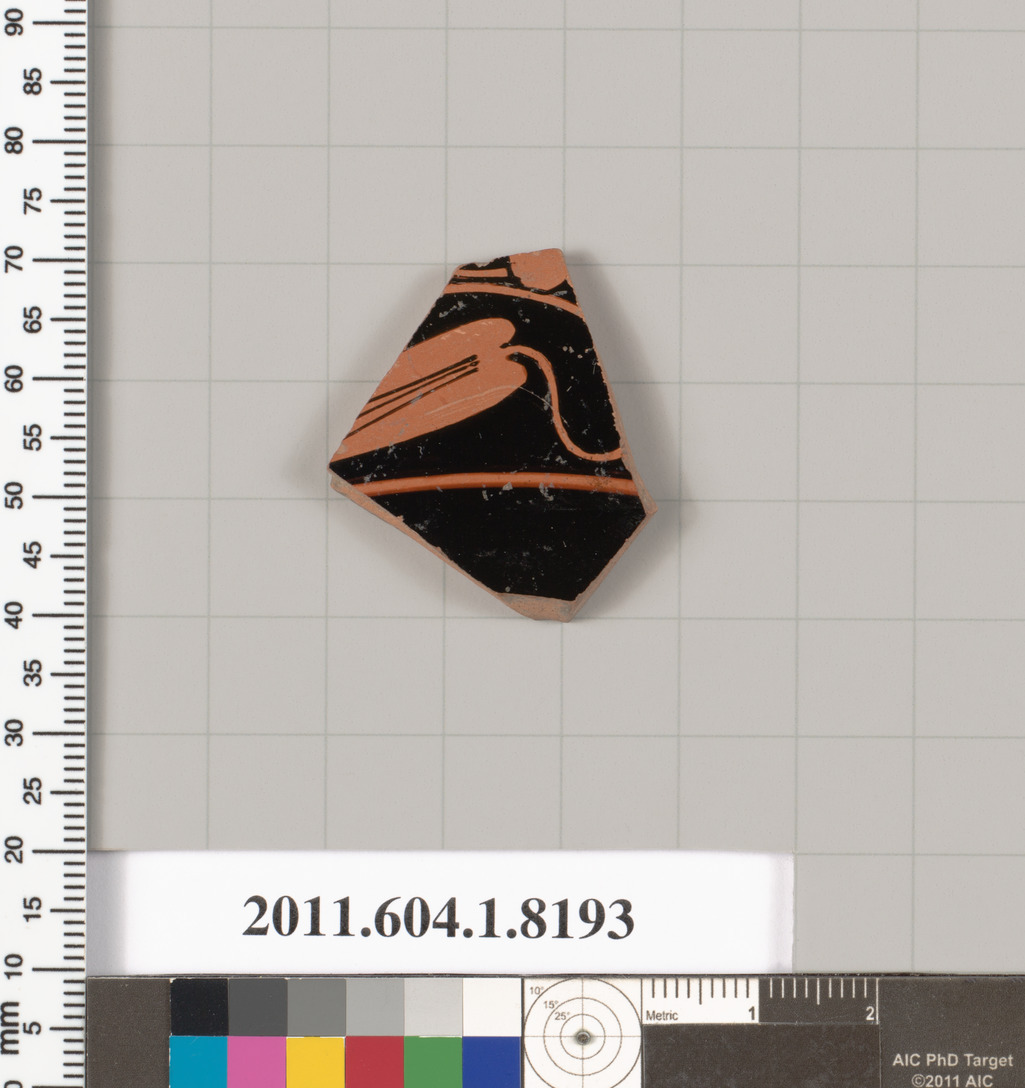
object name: kylix fragment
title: Terracotta fragment of a kylix (drinking cup)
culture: greek, attic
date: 520-510 BCE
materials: terracotta